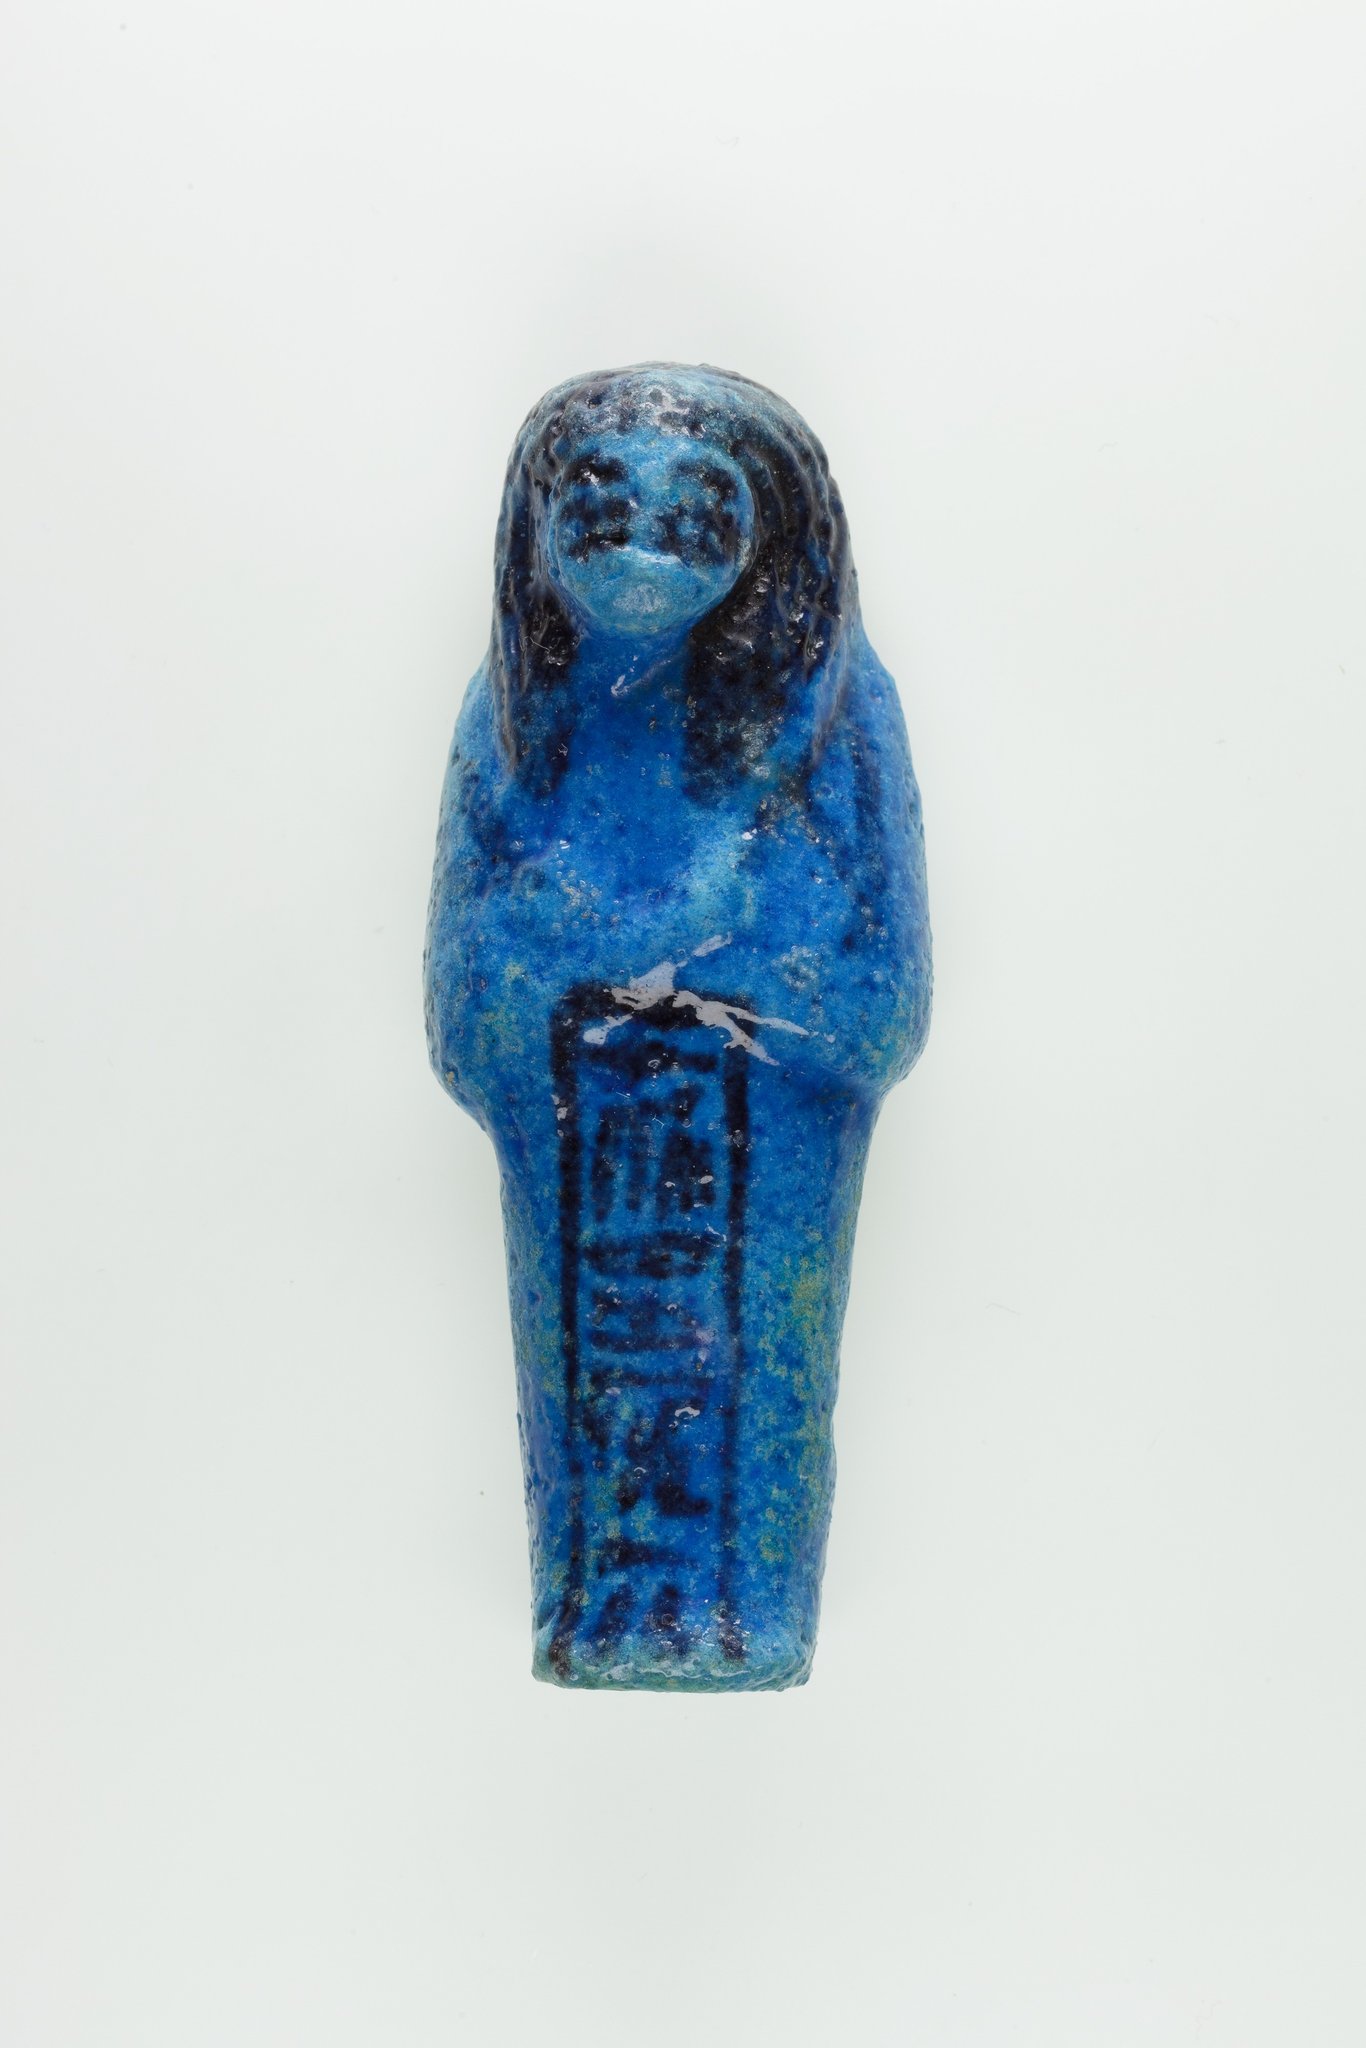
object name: shabti, worker, nauny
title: Worker Shabti of Nauny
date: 1050 BCE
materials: faience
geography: egypt